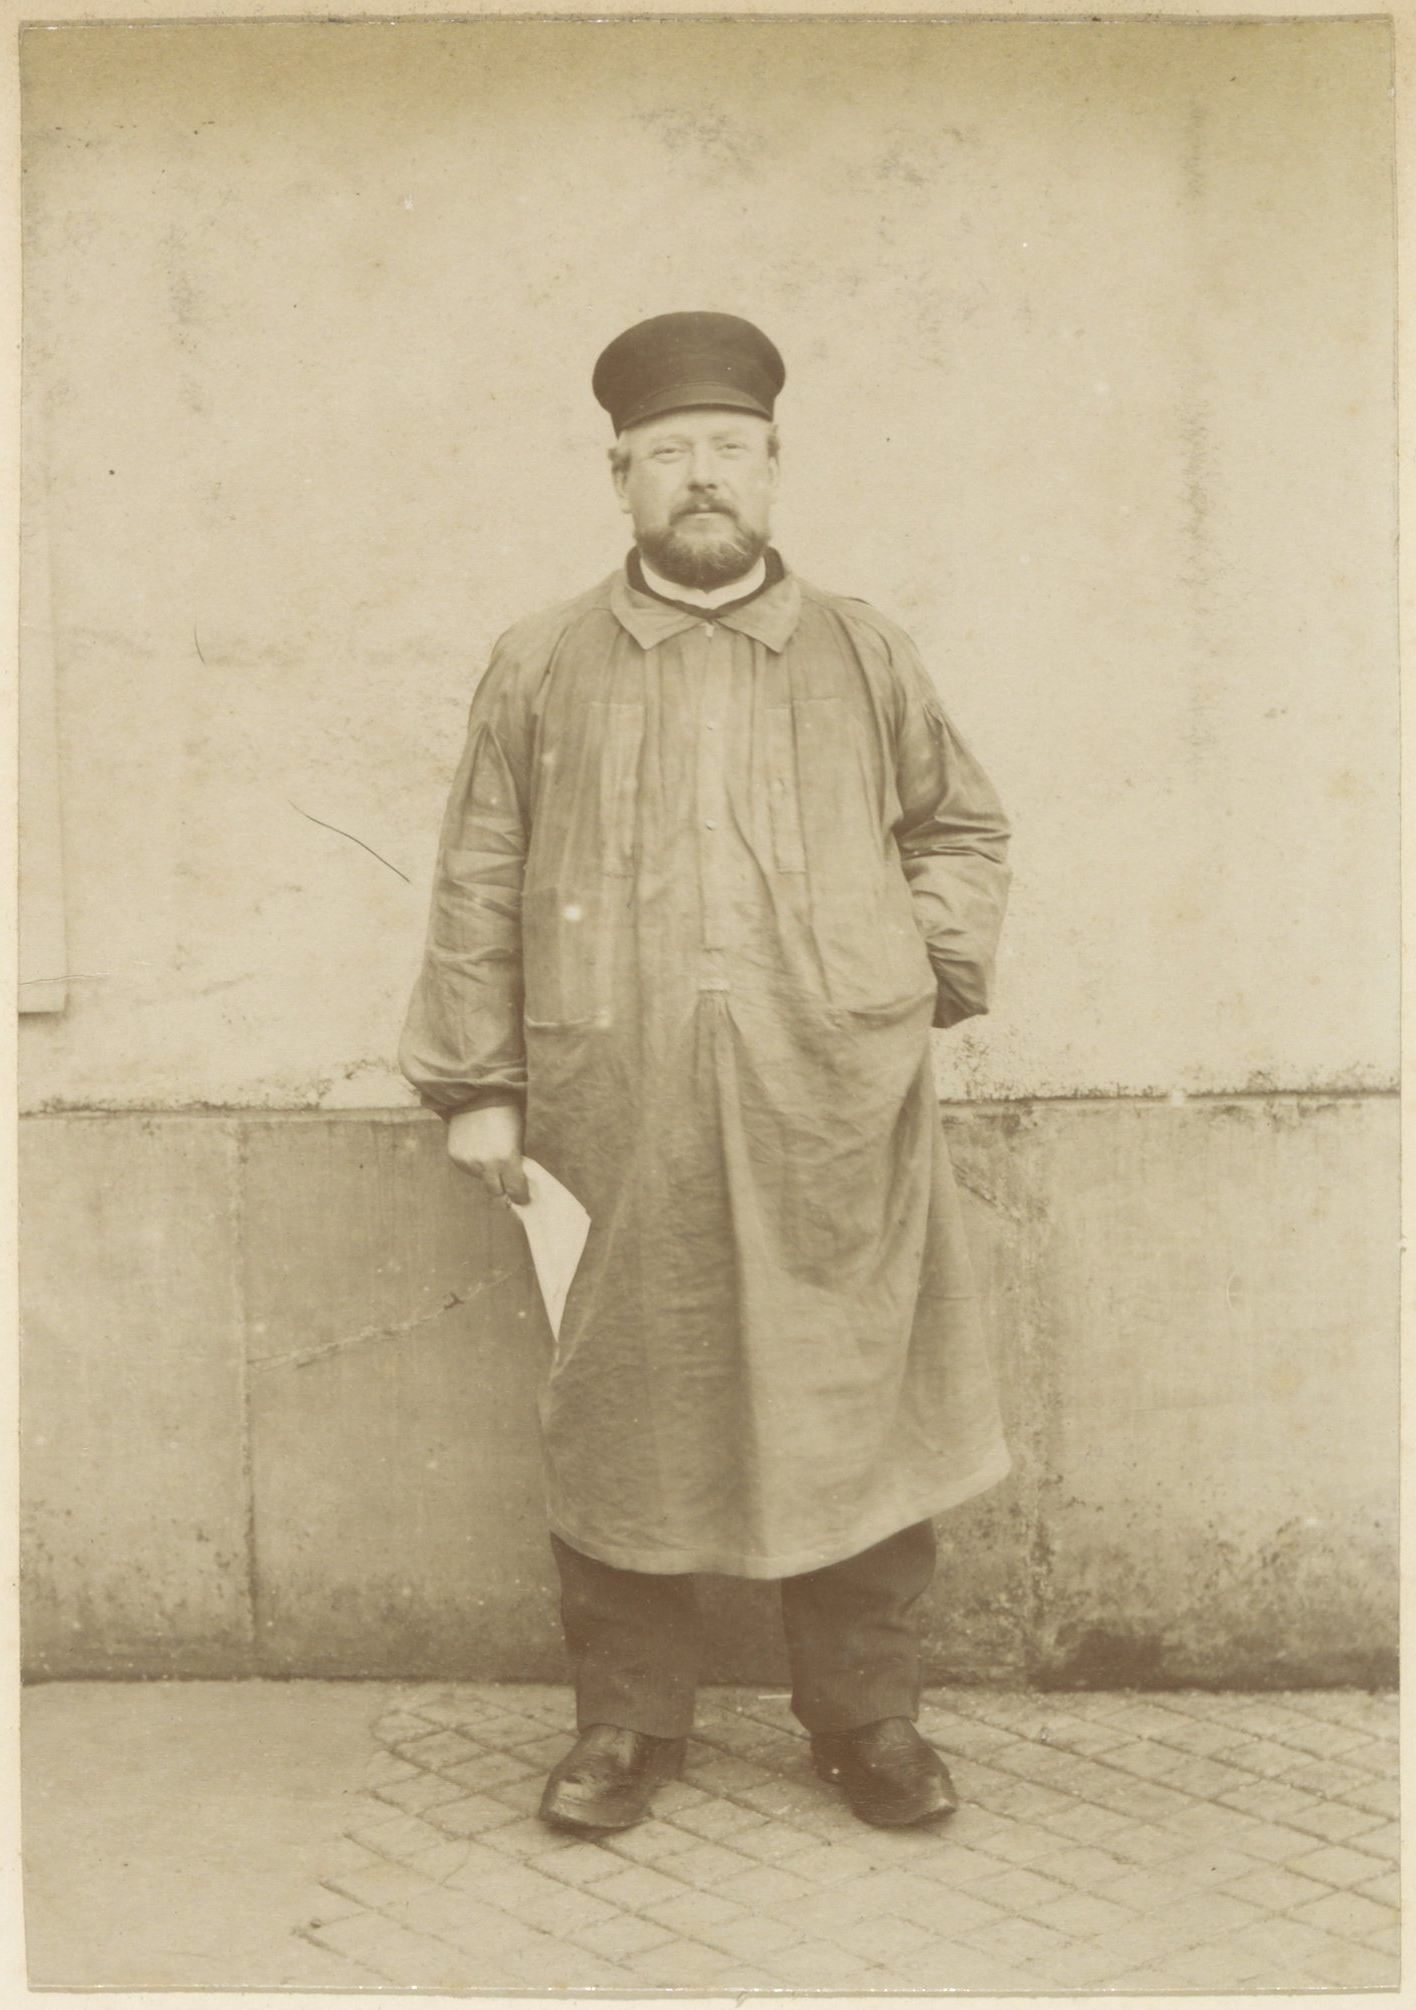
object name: photograph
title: Portret van een man in een overjas, mogelijk een werknemer van distilleerderij Delizy & Doistau Fils in Pantin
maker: Anonymous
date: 1900-1910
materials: paper, photographic support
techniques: albumen print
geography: pantin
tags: adult man, coat, cape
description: Onderdeel van Fotoalbum van een Franse amateurfotograaf met opnames van een familie, distilleerderij Delizy & Doistau Fils, het leger en bezienswaardigheden in Frankrijk.